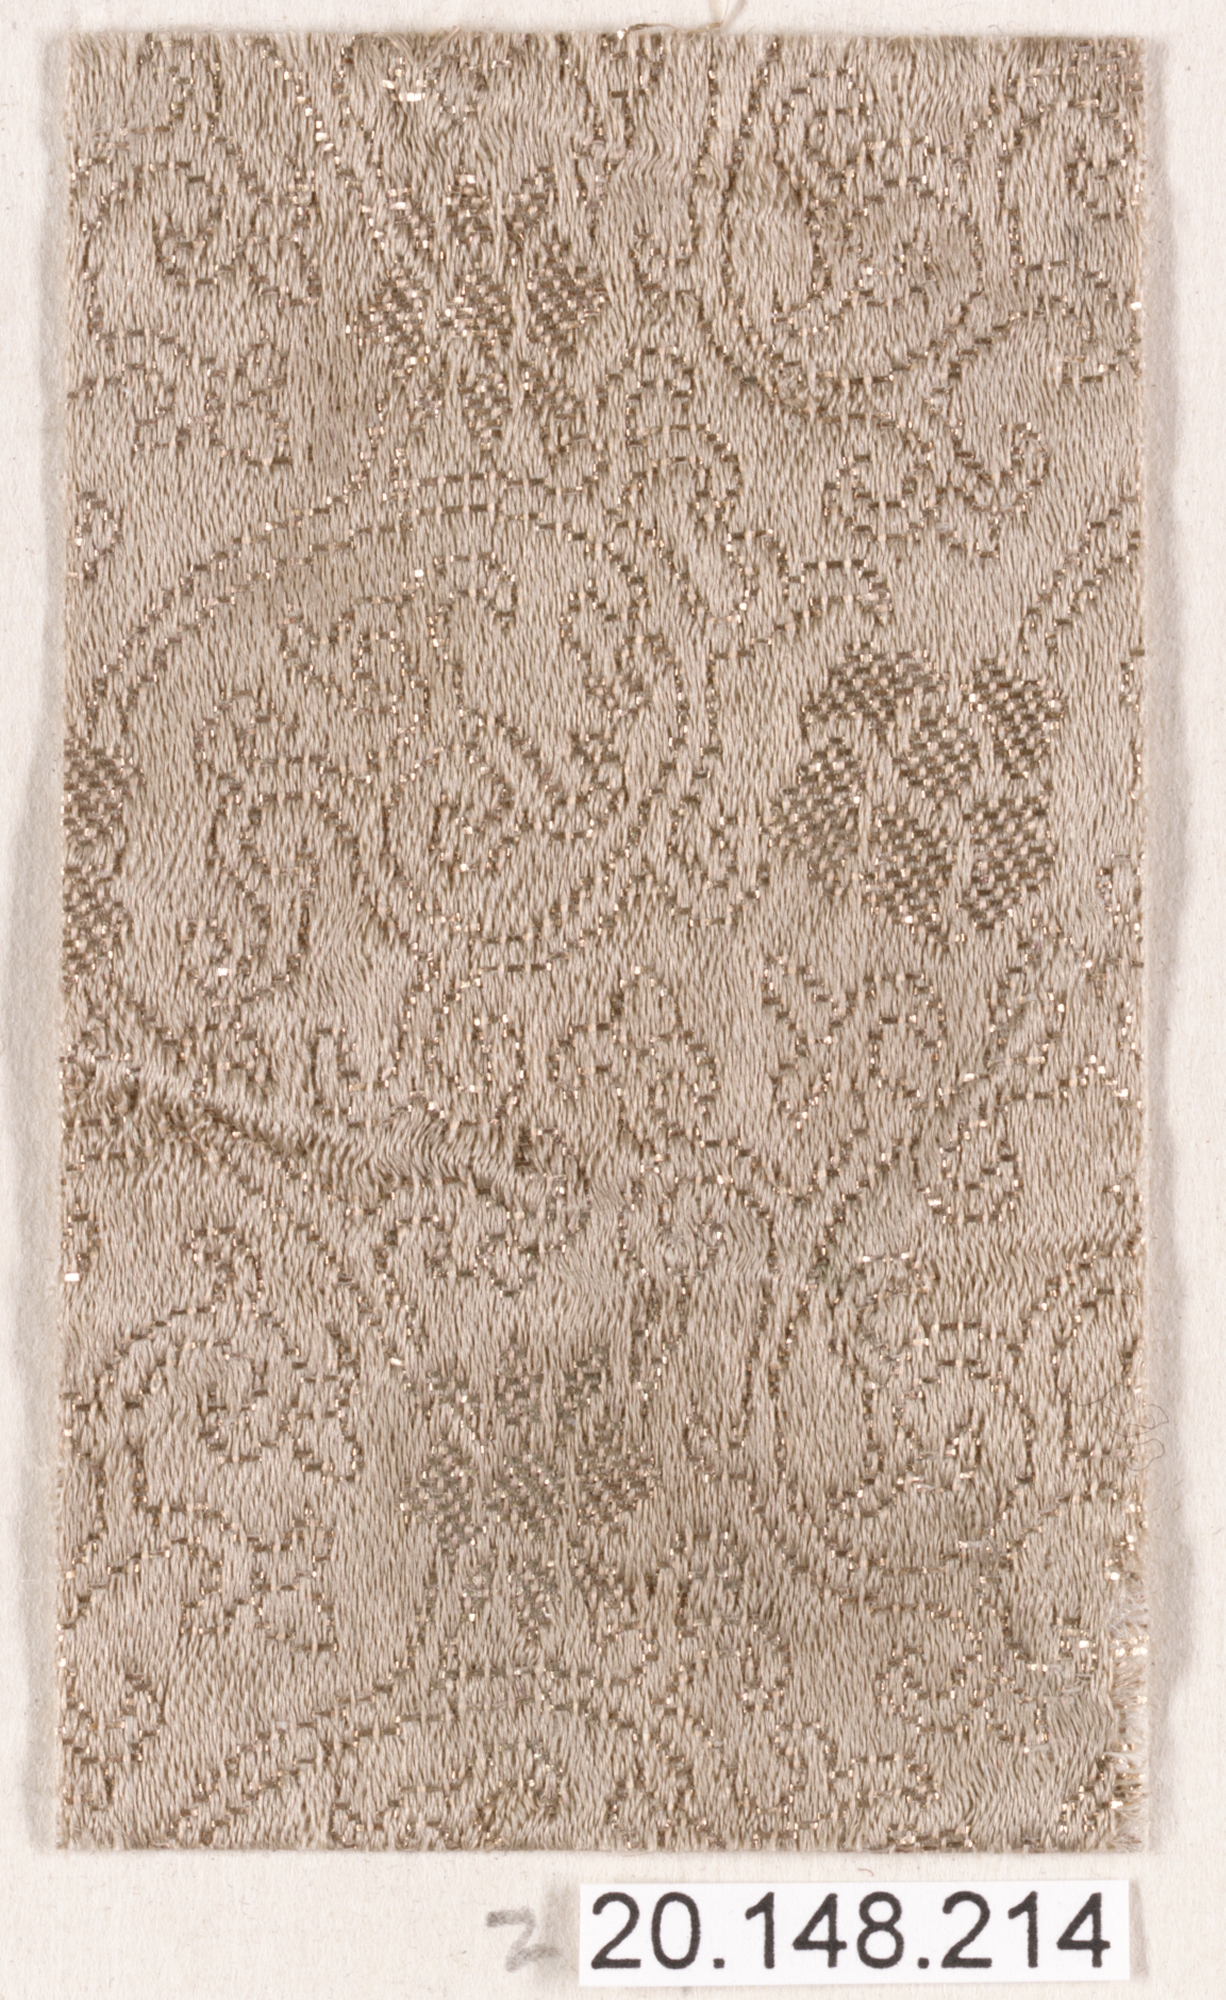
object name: piece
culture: japanese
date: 1601-1700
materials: silk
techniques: compound weave